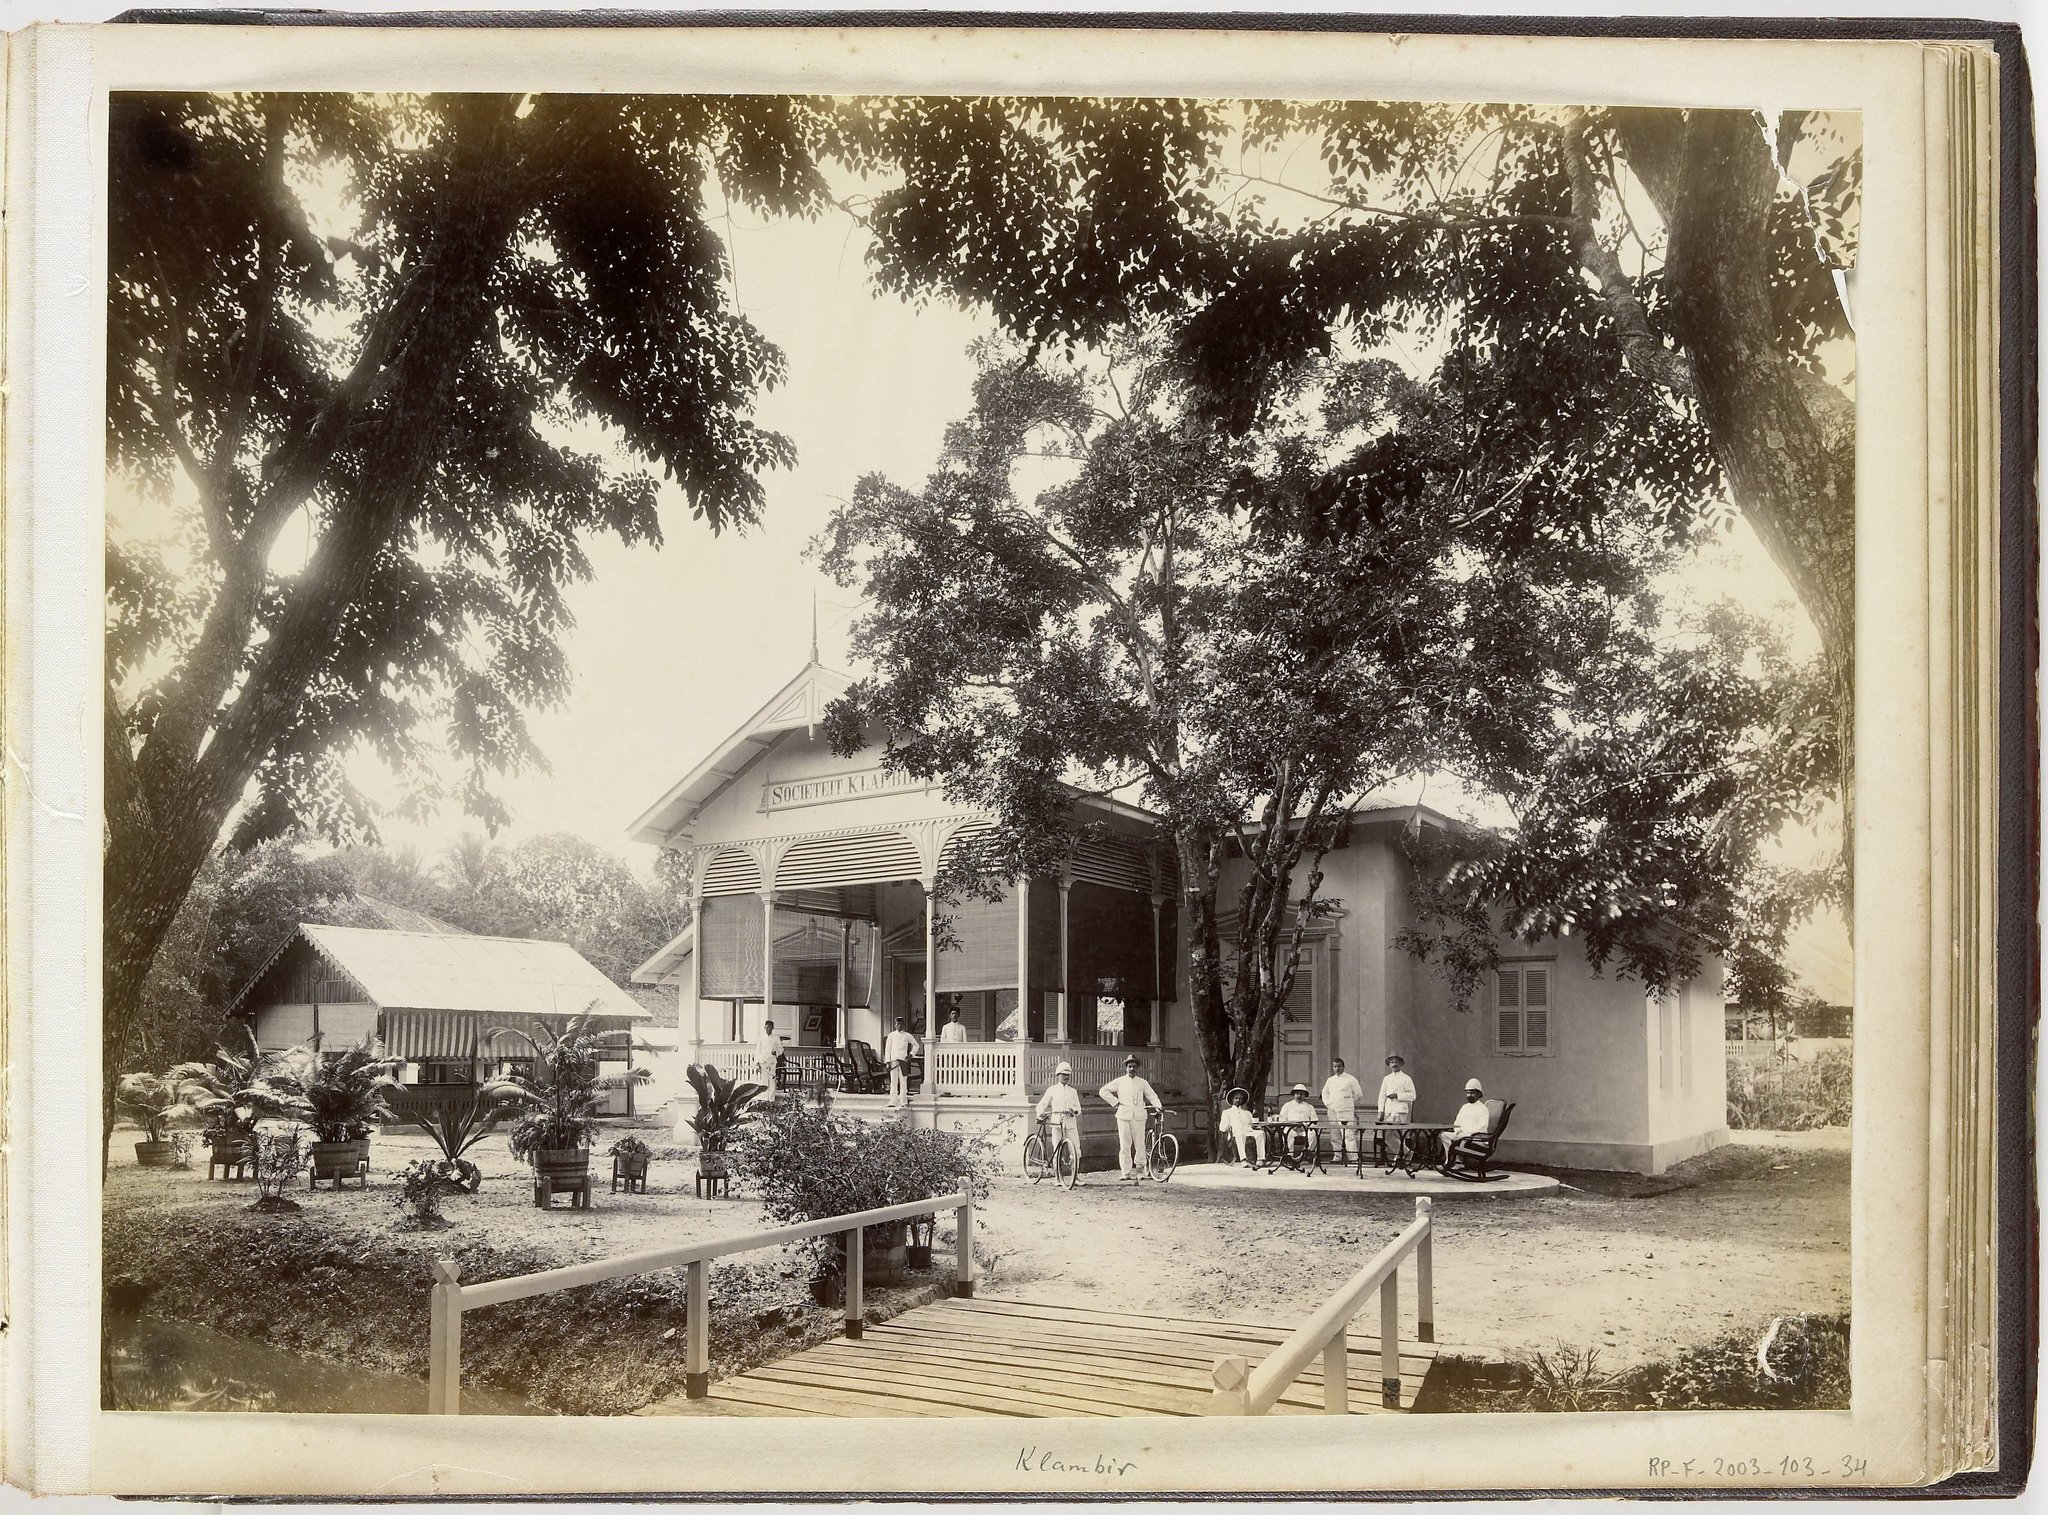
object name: photograph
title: Gezicht op Sociëteit Klambir, Langkat Sumatra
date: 1890-1900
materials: cardboard, paper, photographic support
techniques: albumen print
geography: bindjai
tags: sumatra